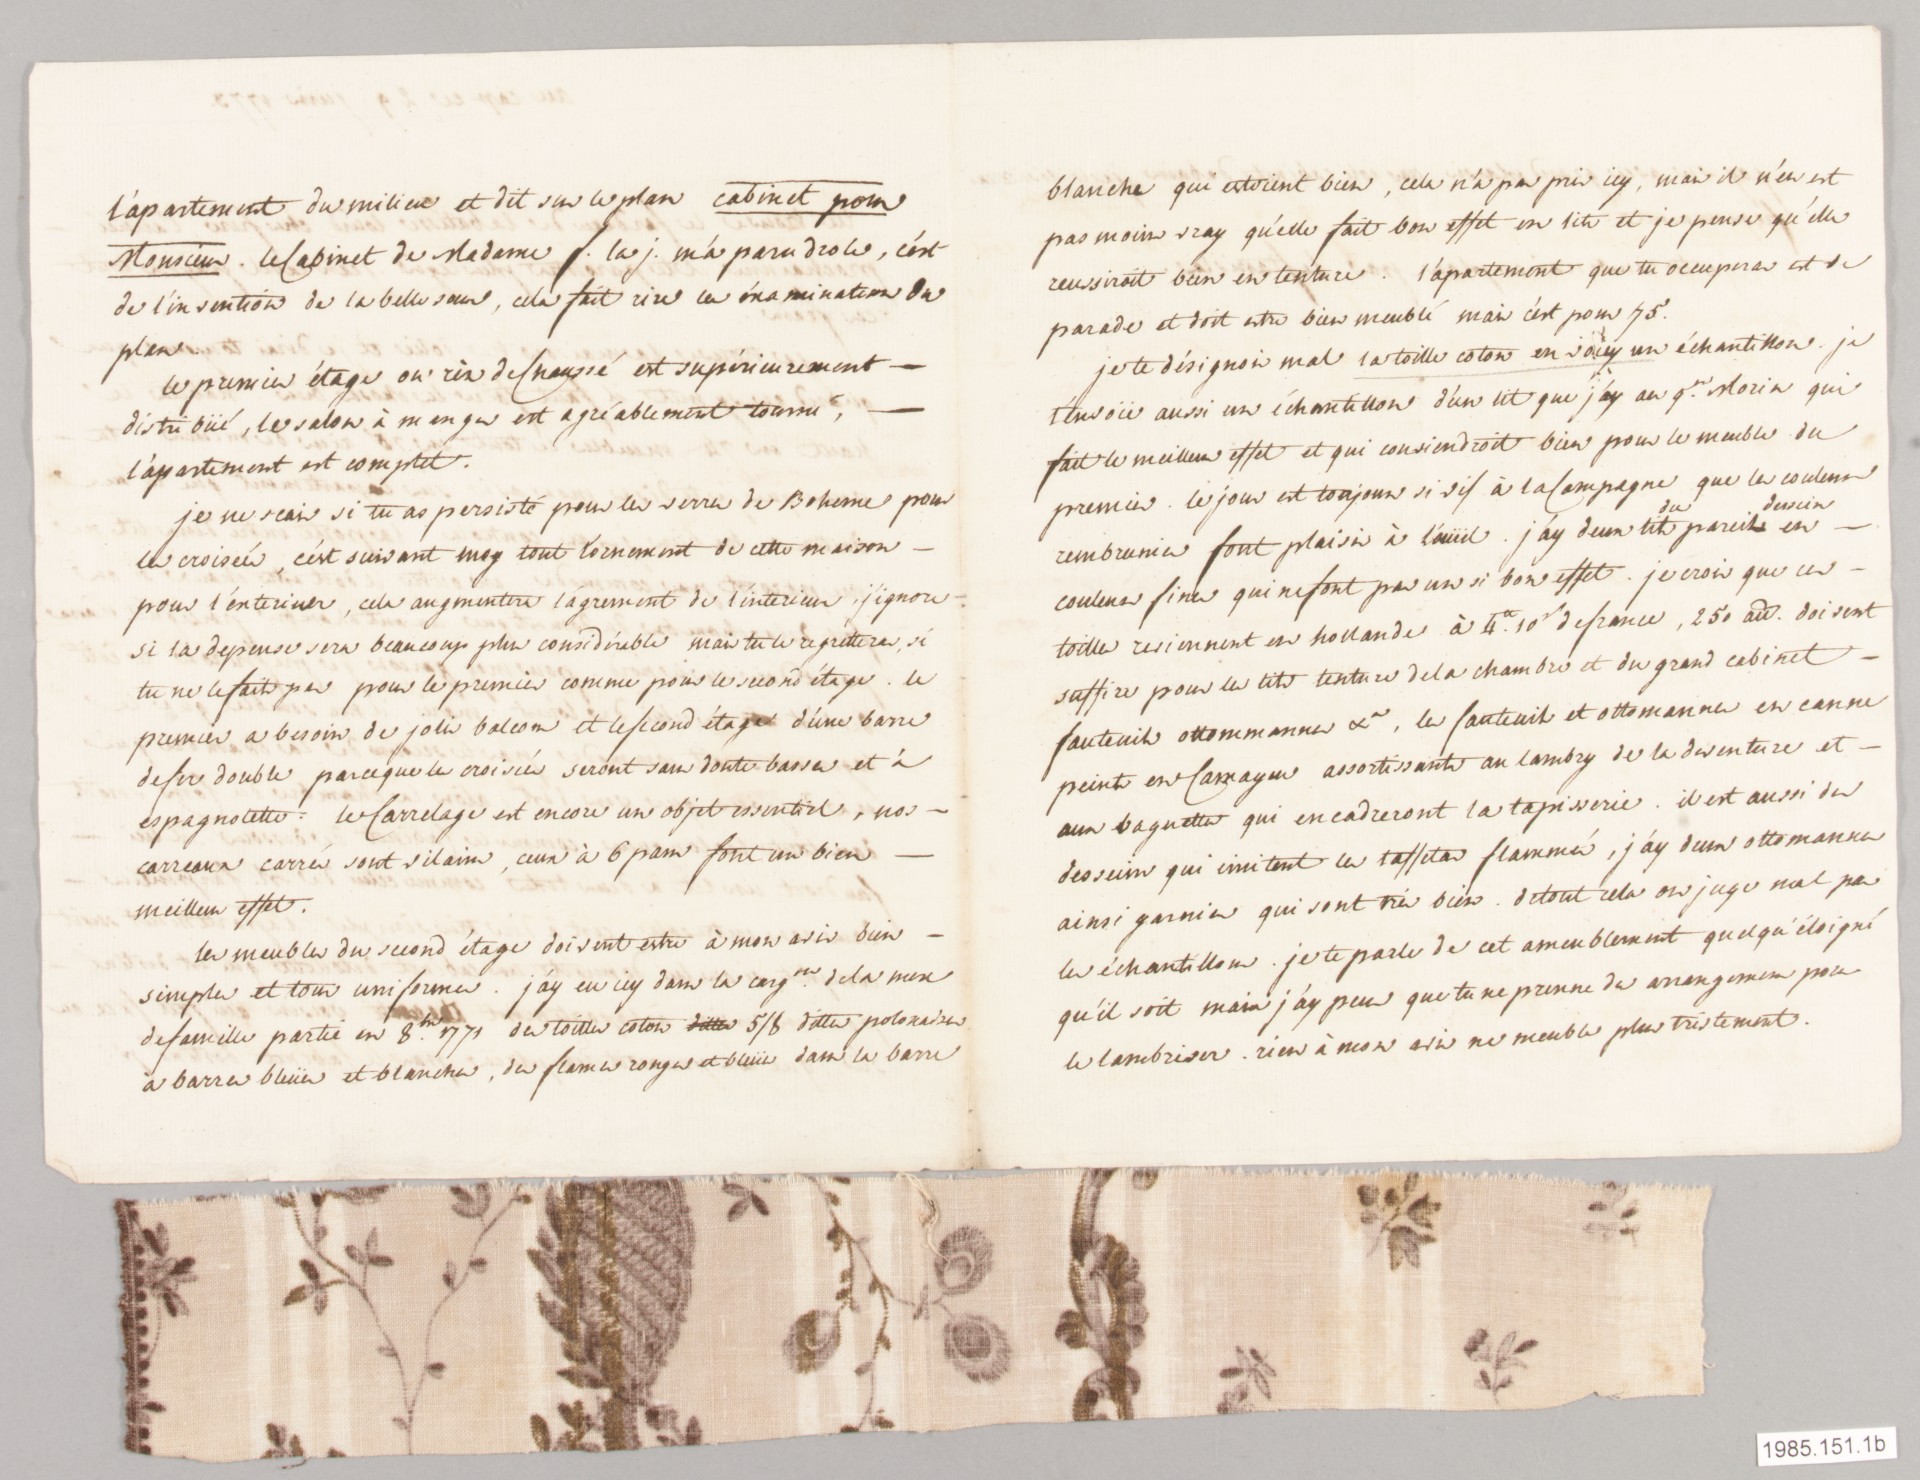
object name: sample and letter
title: Textile swatch to accompany letter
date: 1767-1800